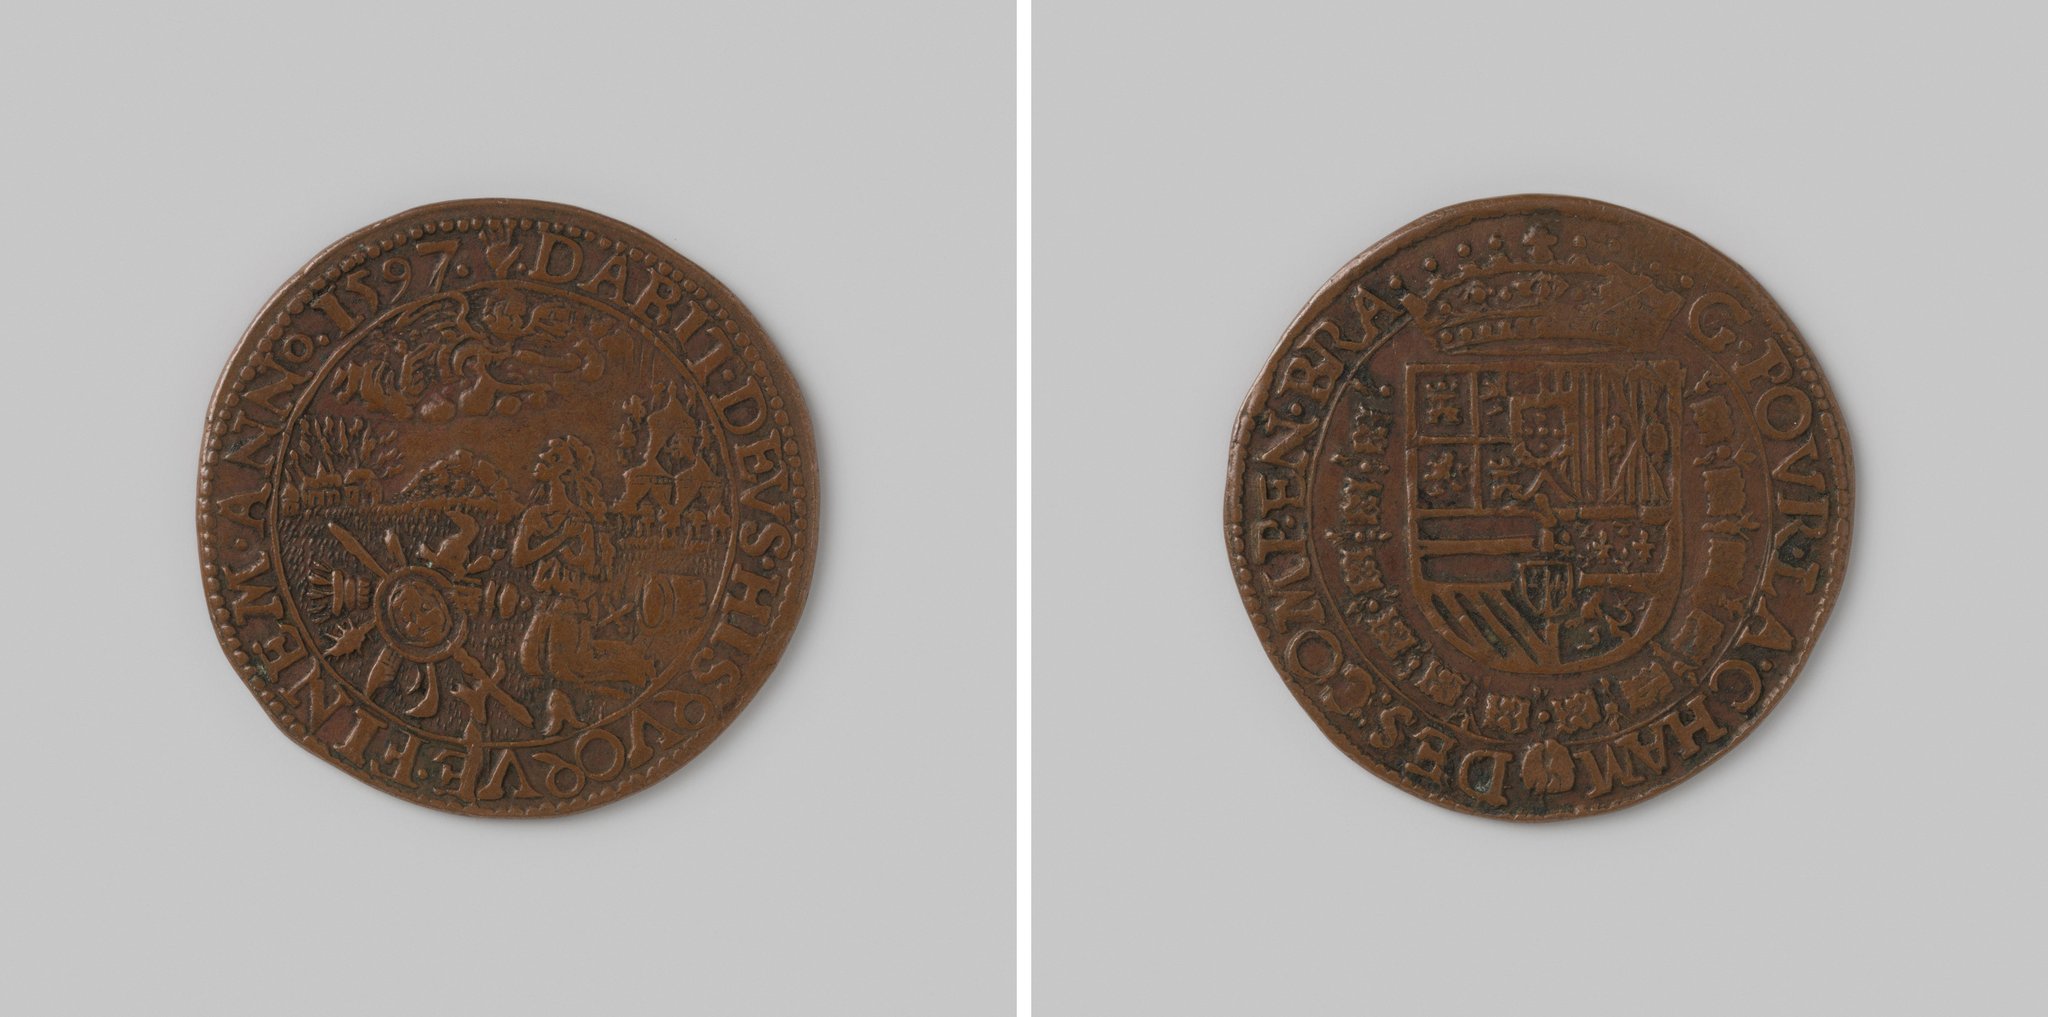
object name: jeton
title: Rekenpenning uit Antwerpen voor Rekenkamer van Brabant op de wens naar vrede 1597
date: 1597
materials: copper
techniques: striking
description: Koperen penning, op de voorzijde België als knielende vrouw te midden van oorlogstuig en brandende steden wordt door een engel aangemoedigd, met omschrift, op de keerzijde het gekroonde Spaanse wapenschild omhangen met de keten van het Gulden Vlies, met omschrift.